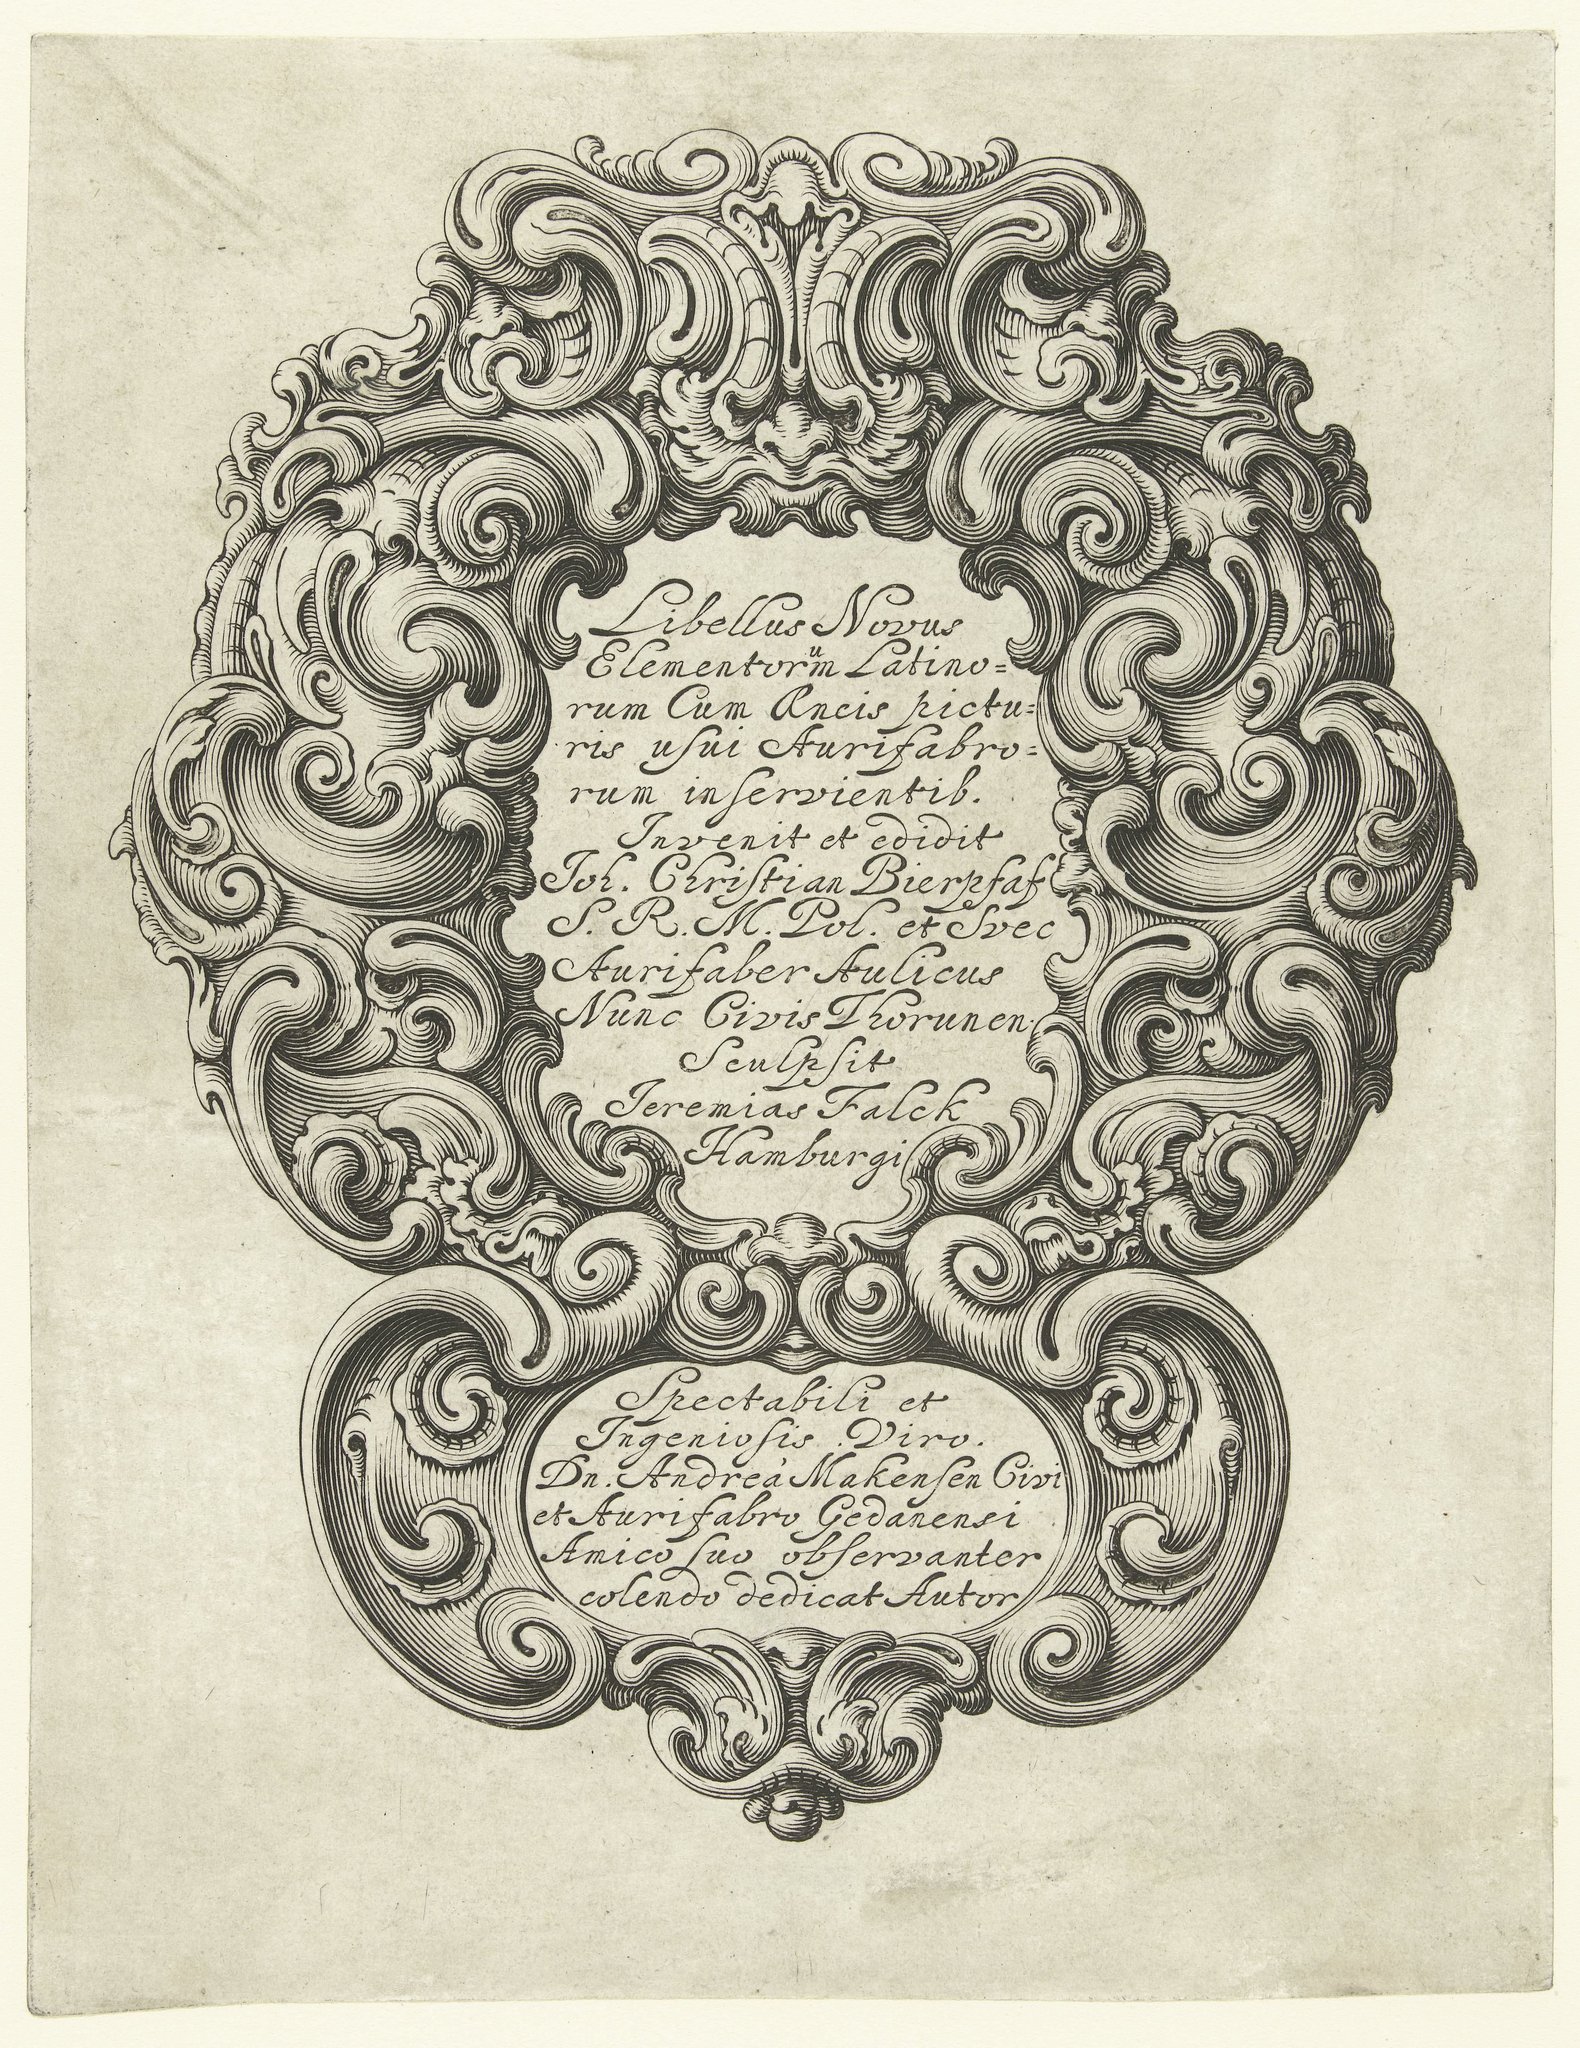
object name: titelblad, titelpagina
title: Titelblad: Libellus Novus Elementorum Latinorum Cum AEneis picturis usui Aurifabrorum inservientib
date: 1645-1650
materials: paper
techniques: engraving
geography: hamburg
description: De tekst staat in twee compartimenten van één cartouche. Titelblad uit serie van 26 bladen met letters uit het alfabet.